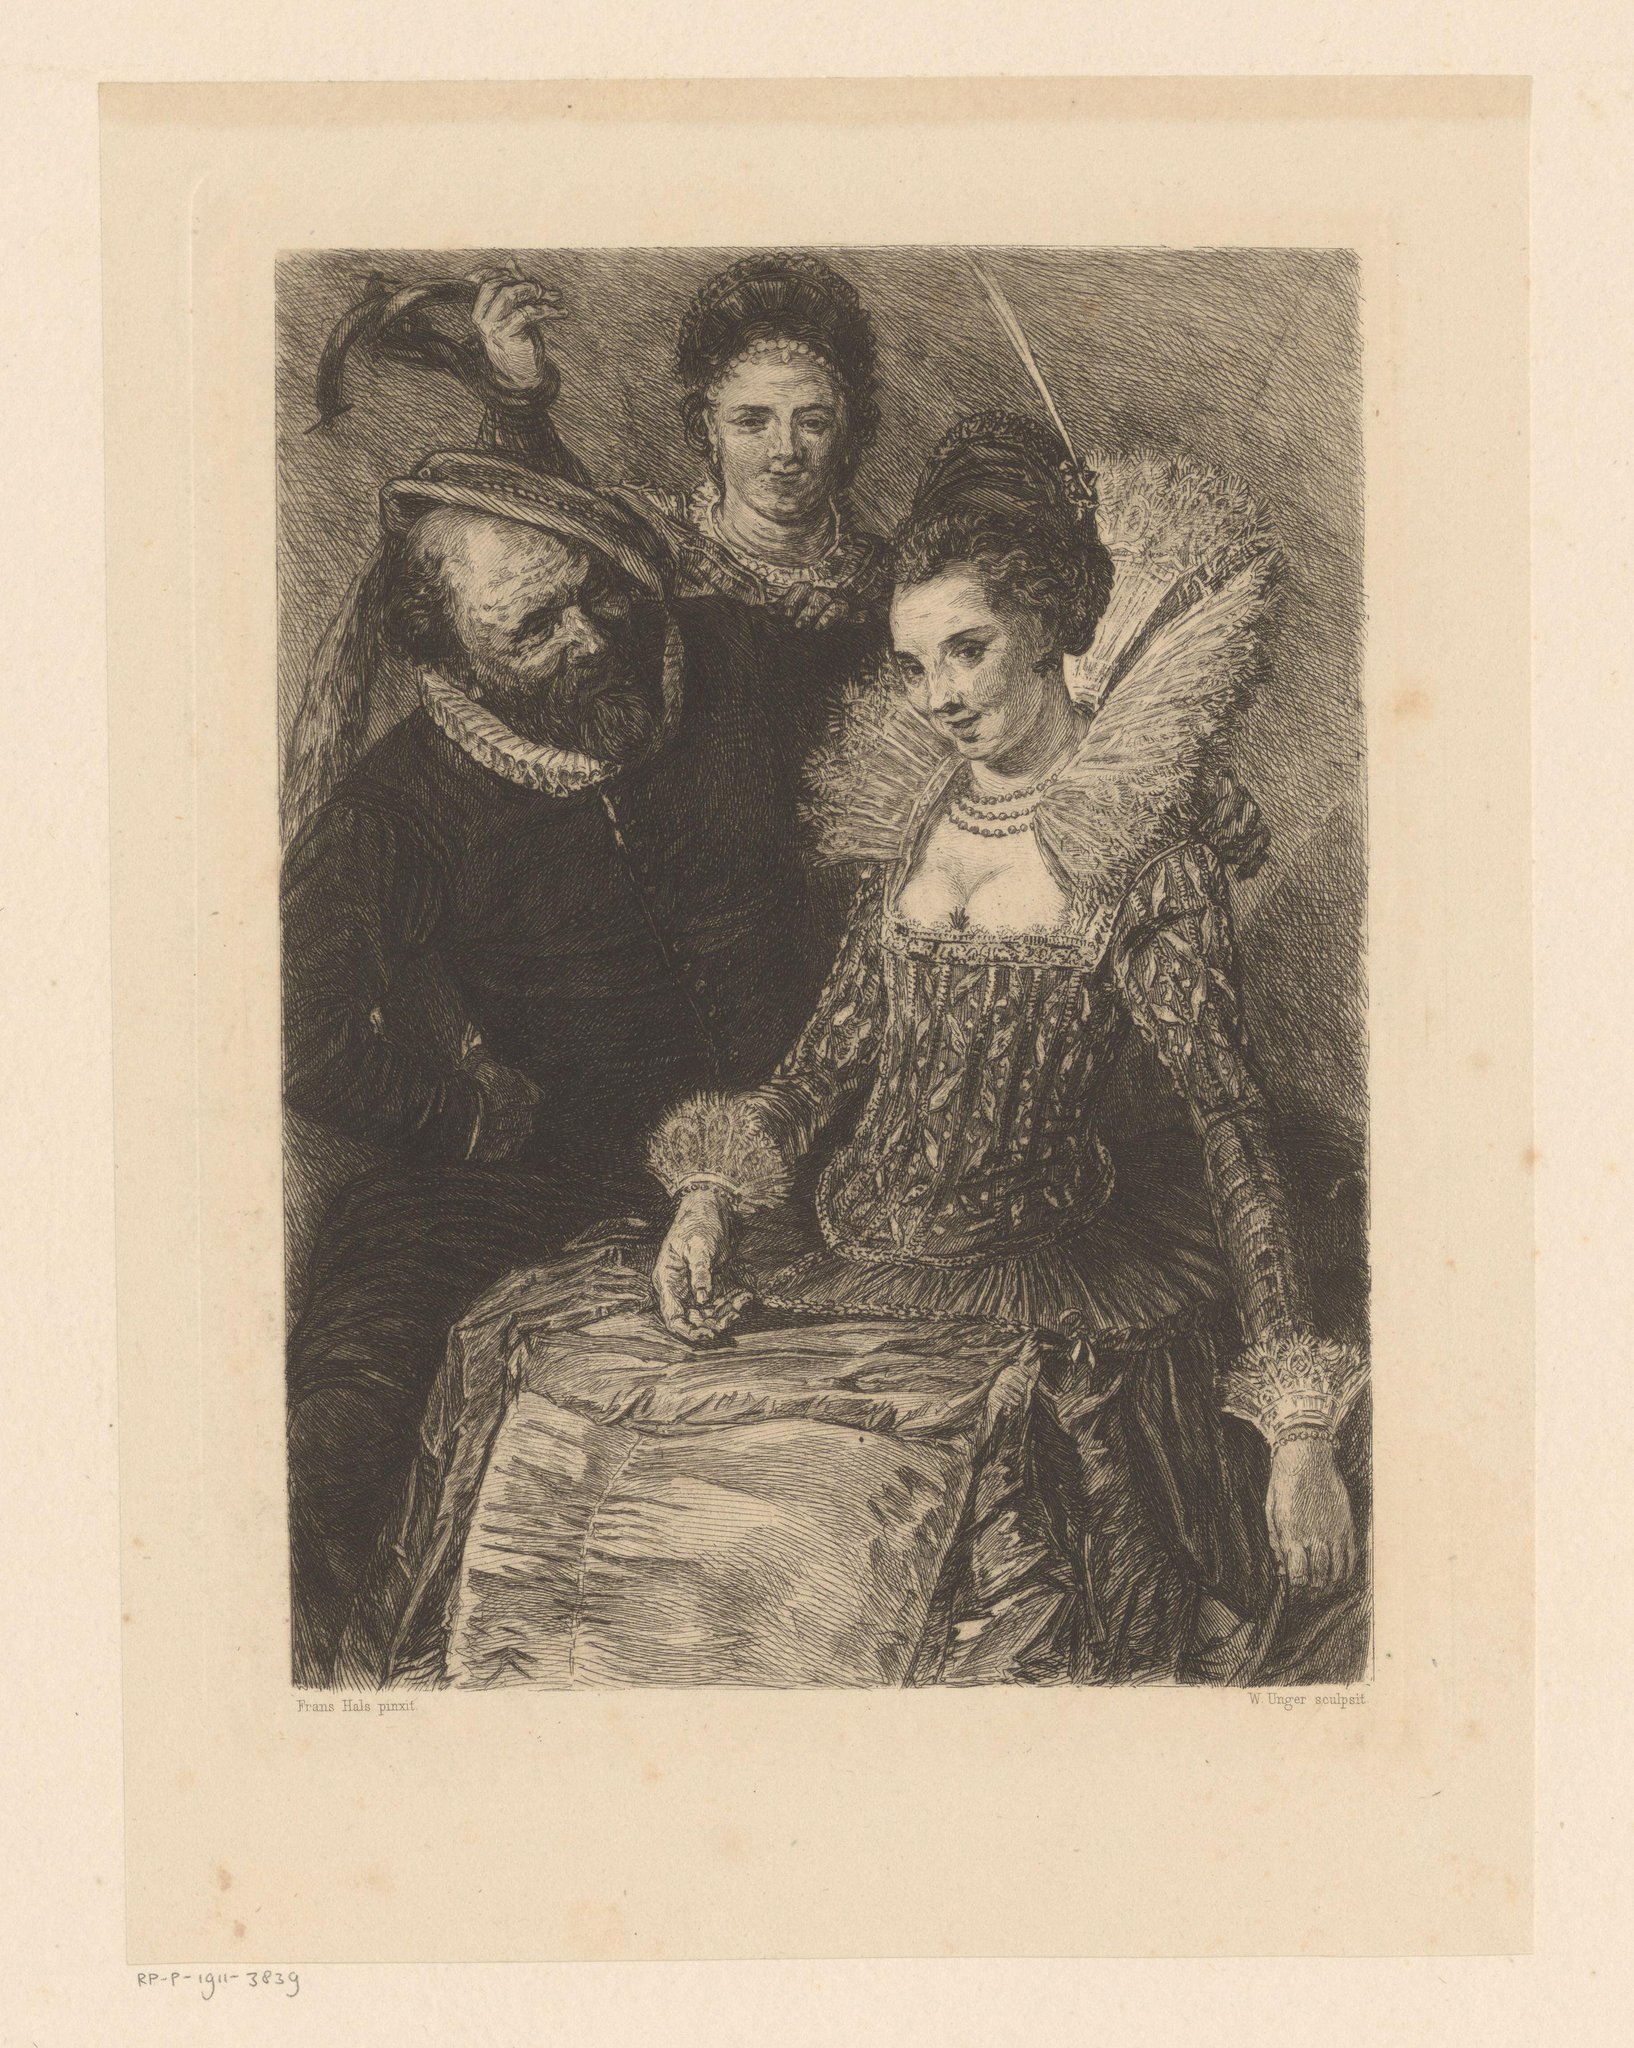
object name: print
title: Vrolijk gezelschap van drie figuren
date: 1847-1889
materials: paper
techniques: etching, intaglio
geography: germany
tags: private festivities, merry company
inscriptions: collector's mark: Lugt 2228